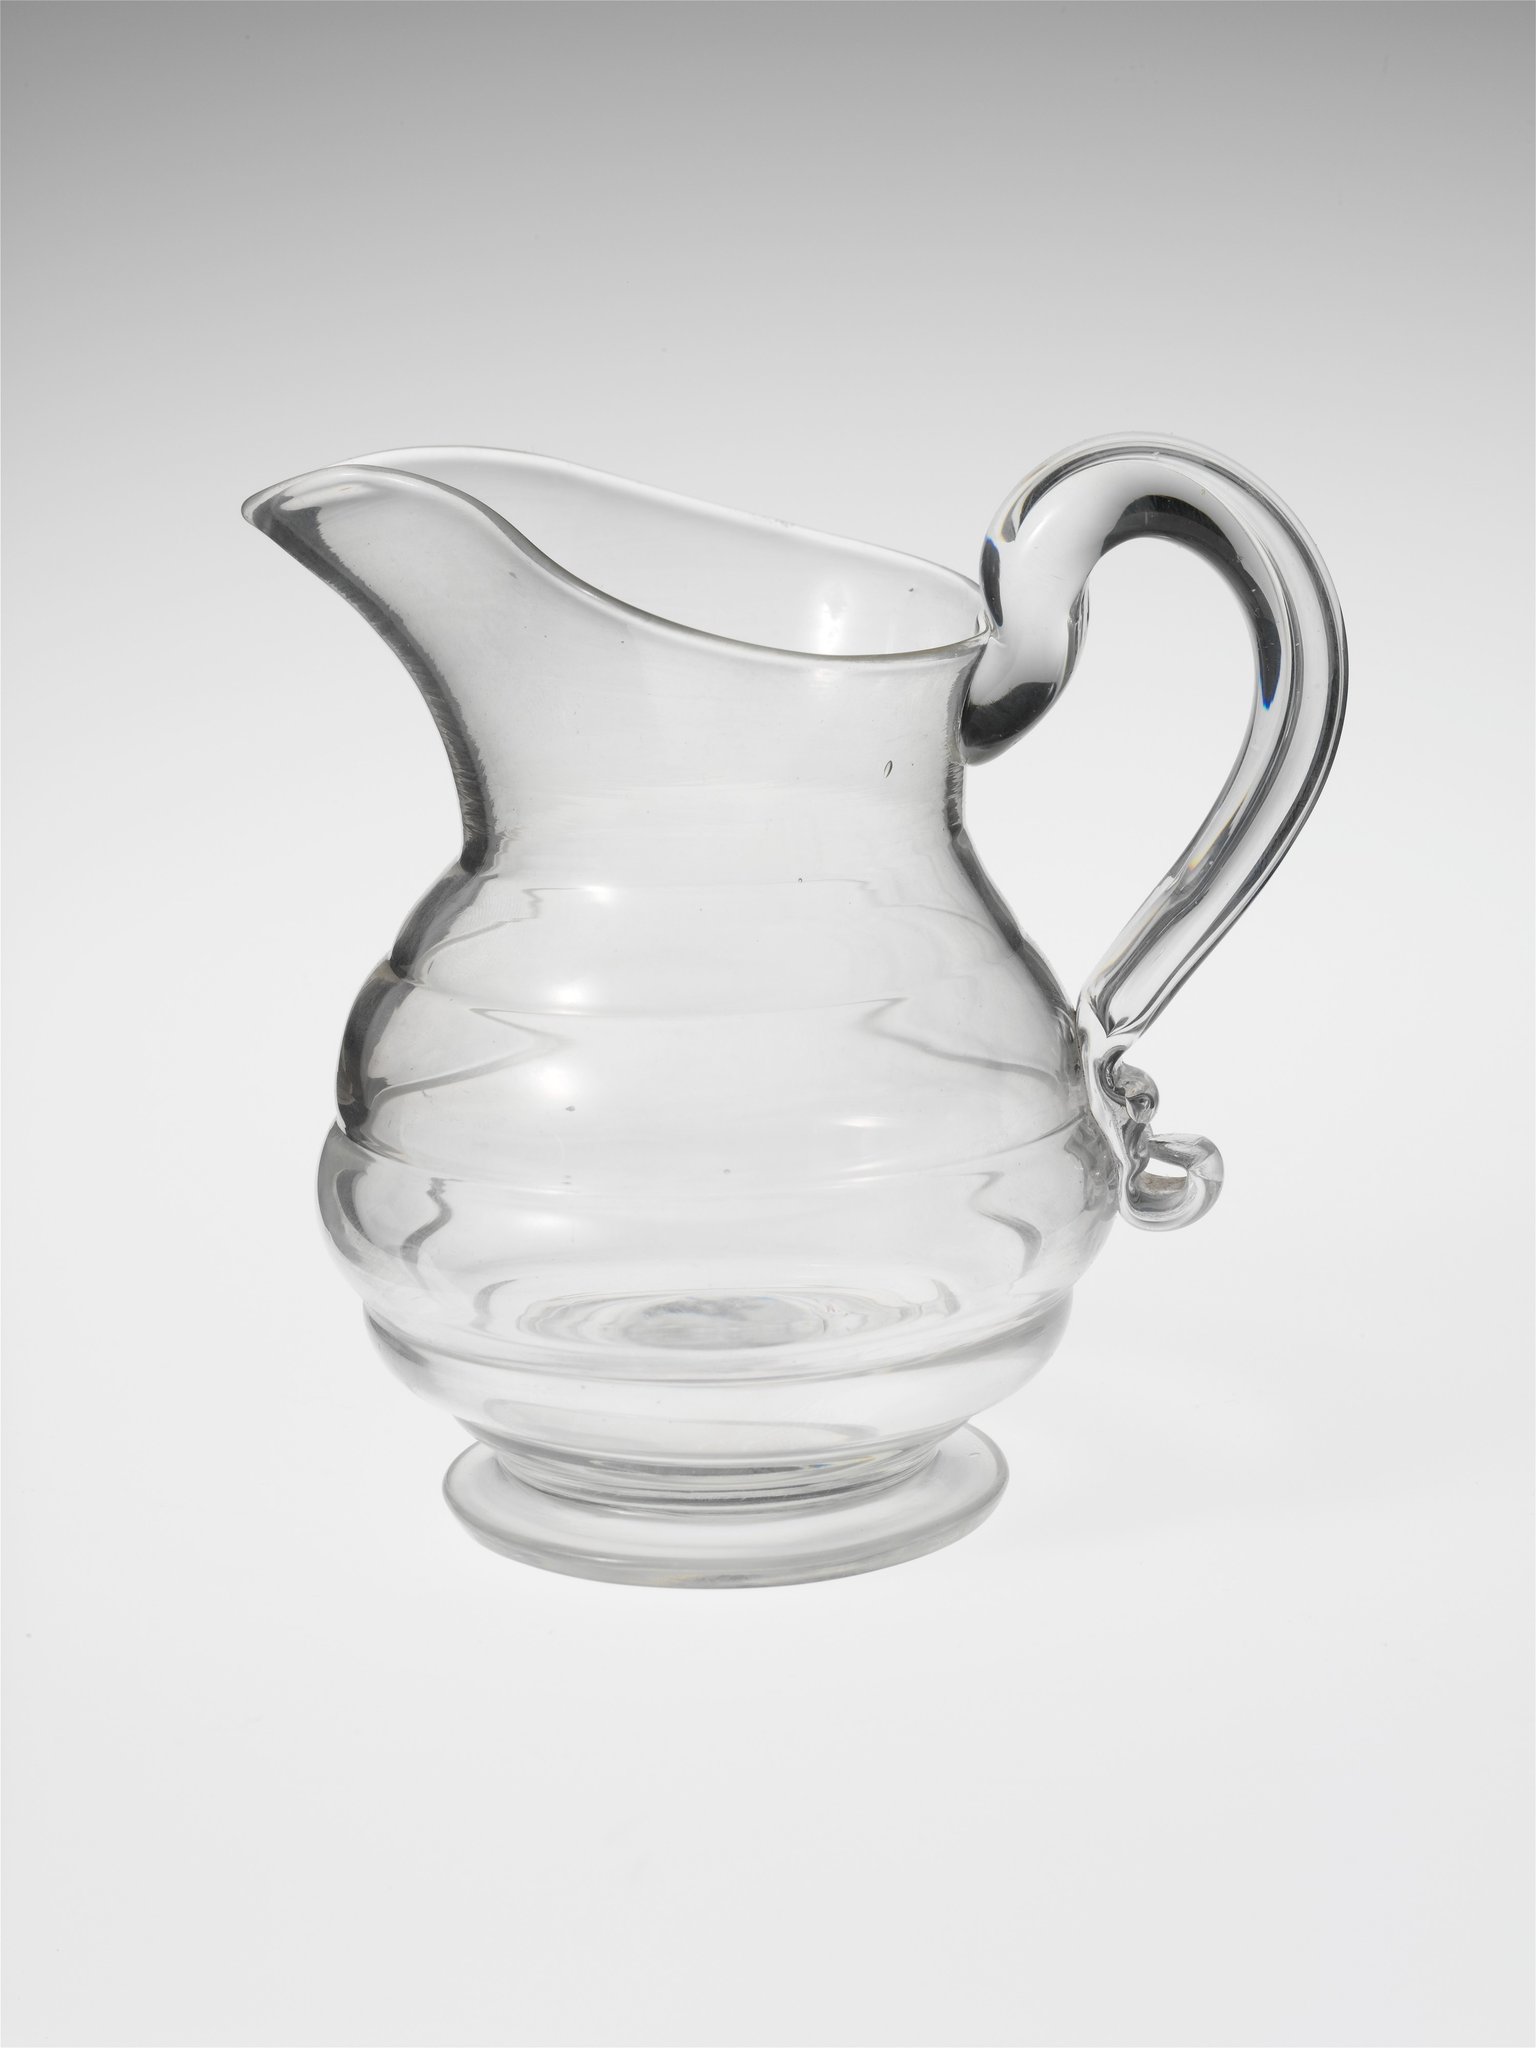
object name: pitcher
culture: american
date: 1800-1830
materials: glass, lead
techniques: glassblowing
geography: united states